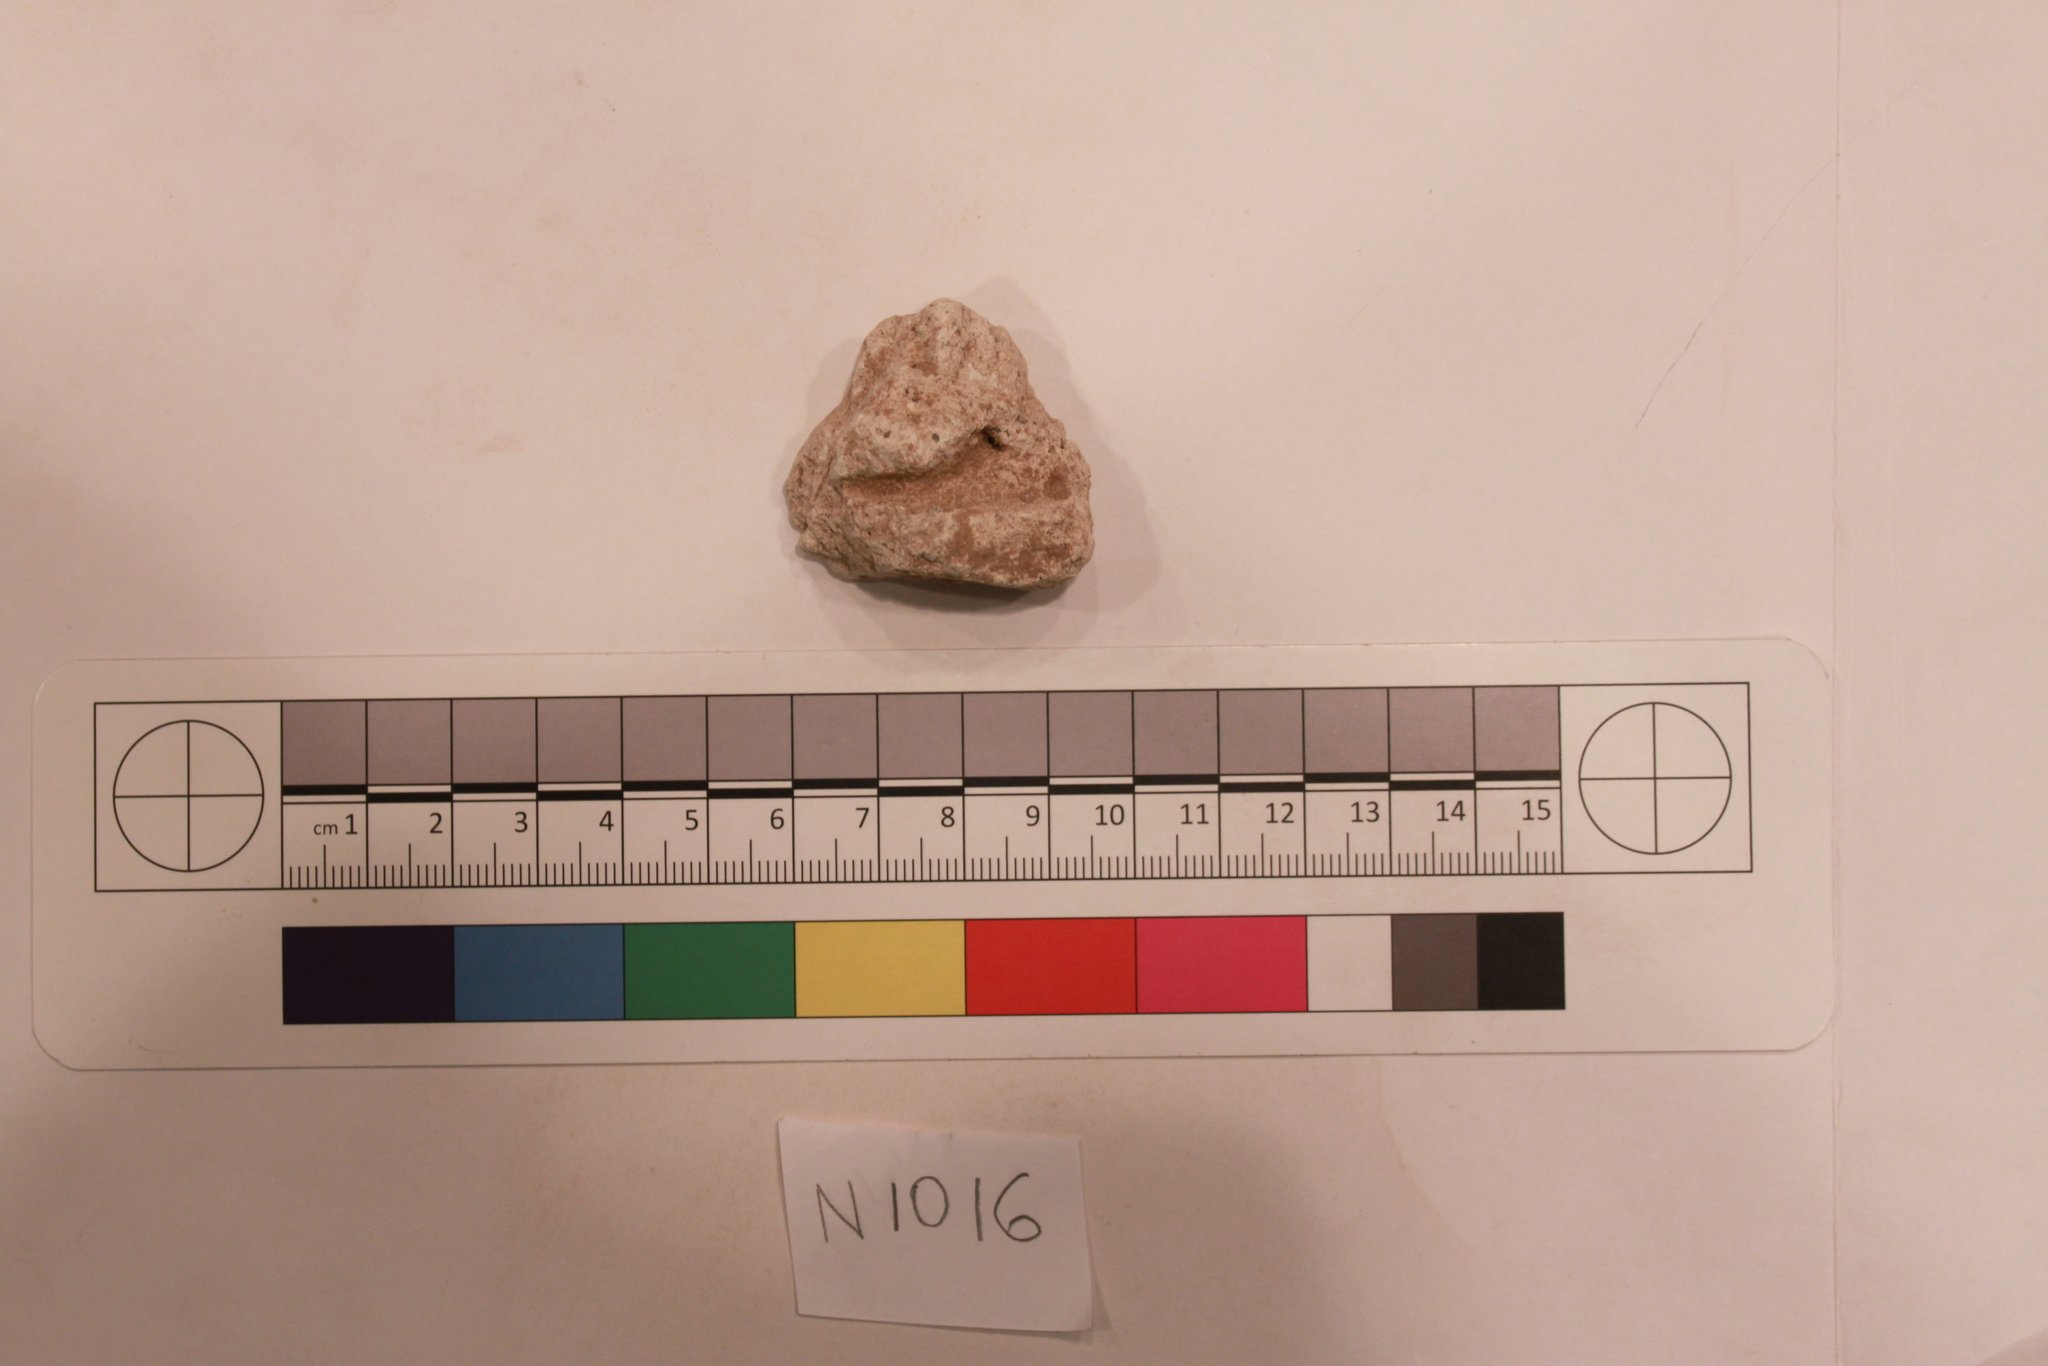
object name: fragment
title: Stucco Fragment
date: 701-1200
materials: plaster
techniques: carving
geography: iran